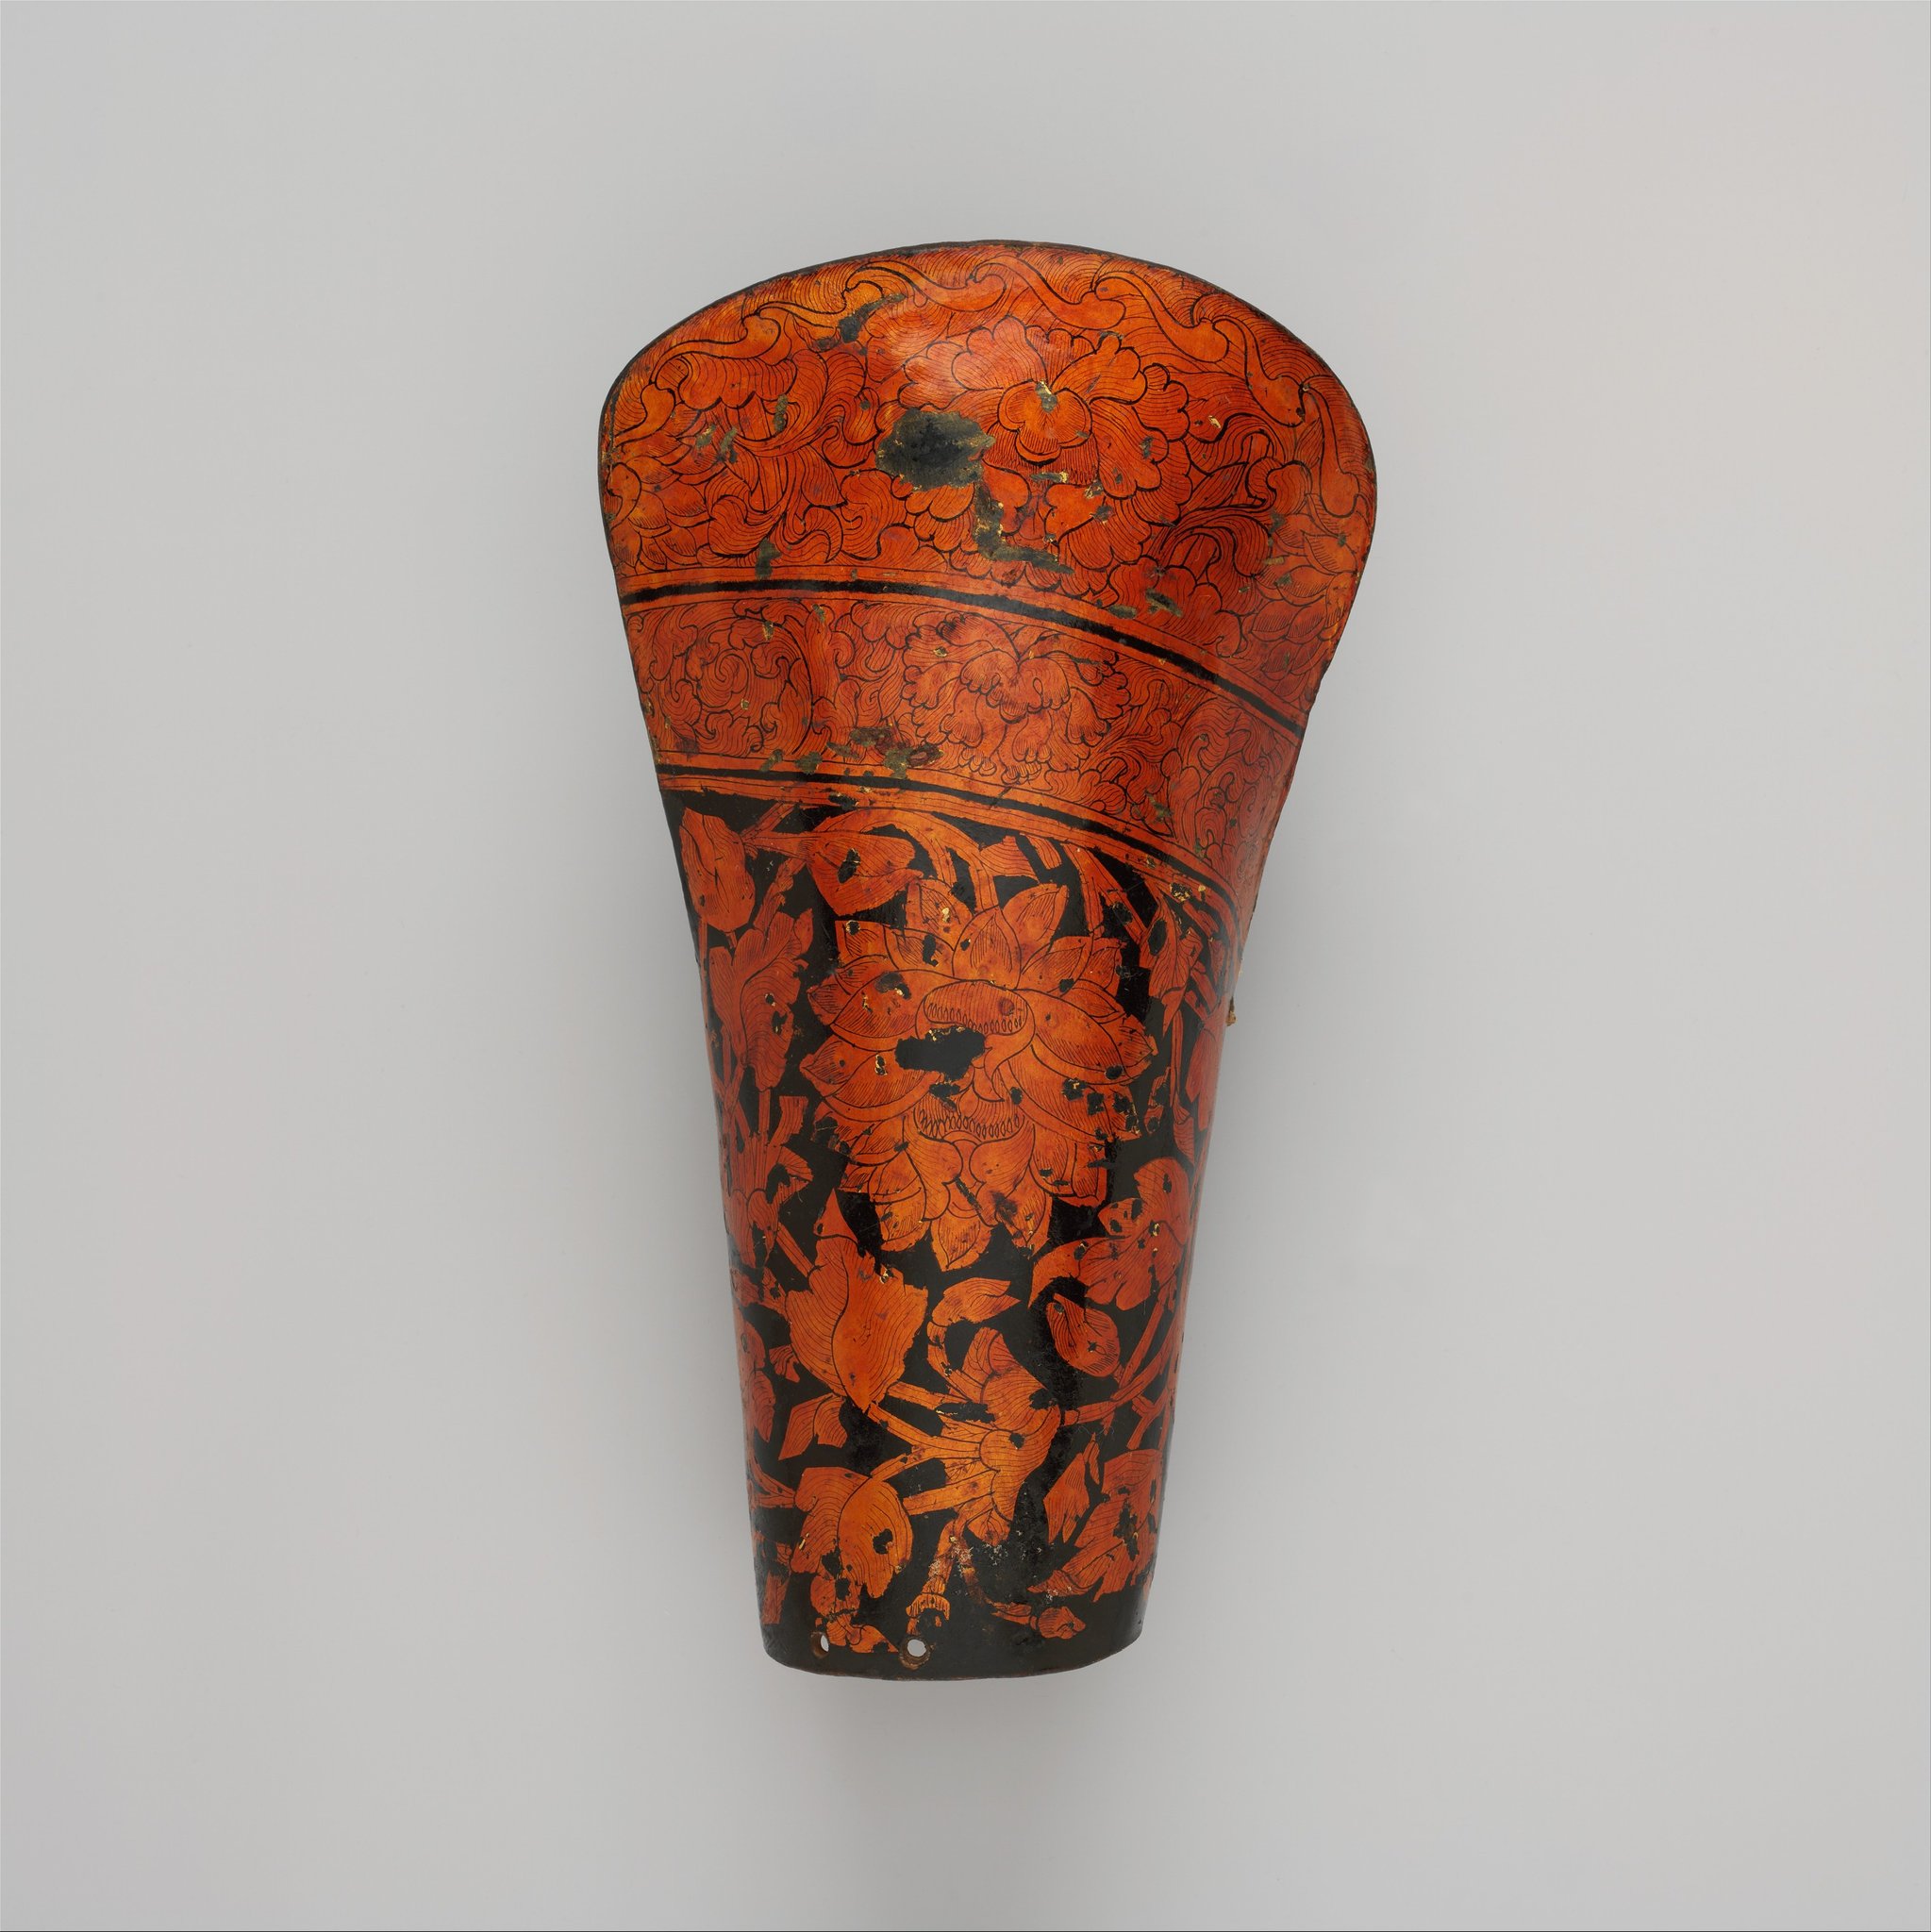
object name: arm guard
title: Forearm Guard for the Left Arm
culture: mongolian or tibetan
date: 1401-1600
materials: gold, leather, pigment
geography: mongolia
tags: flowers